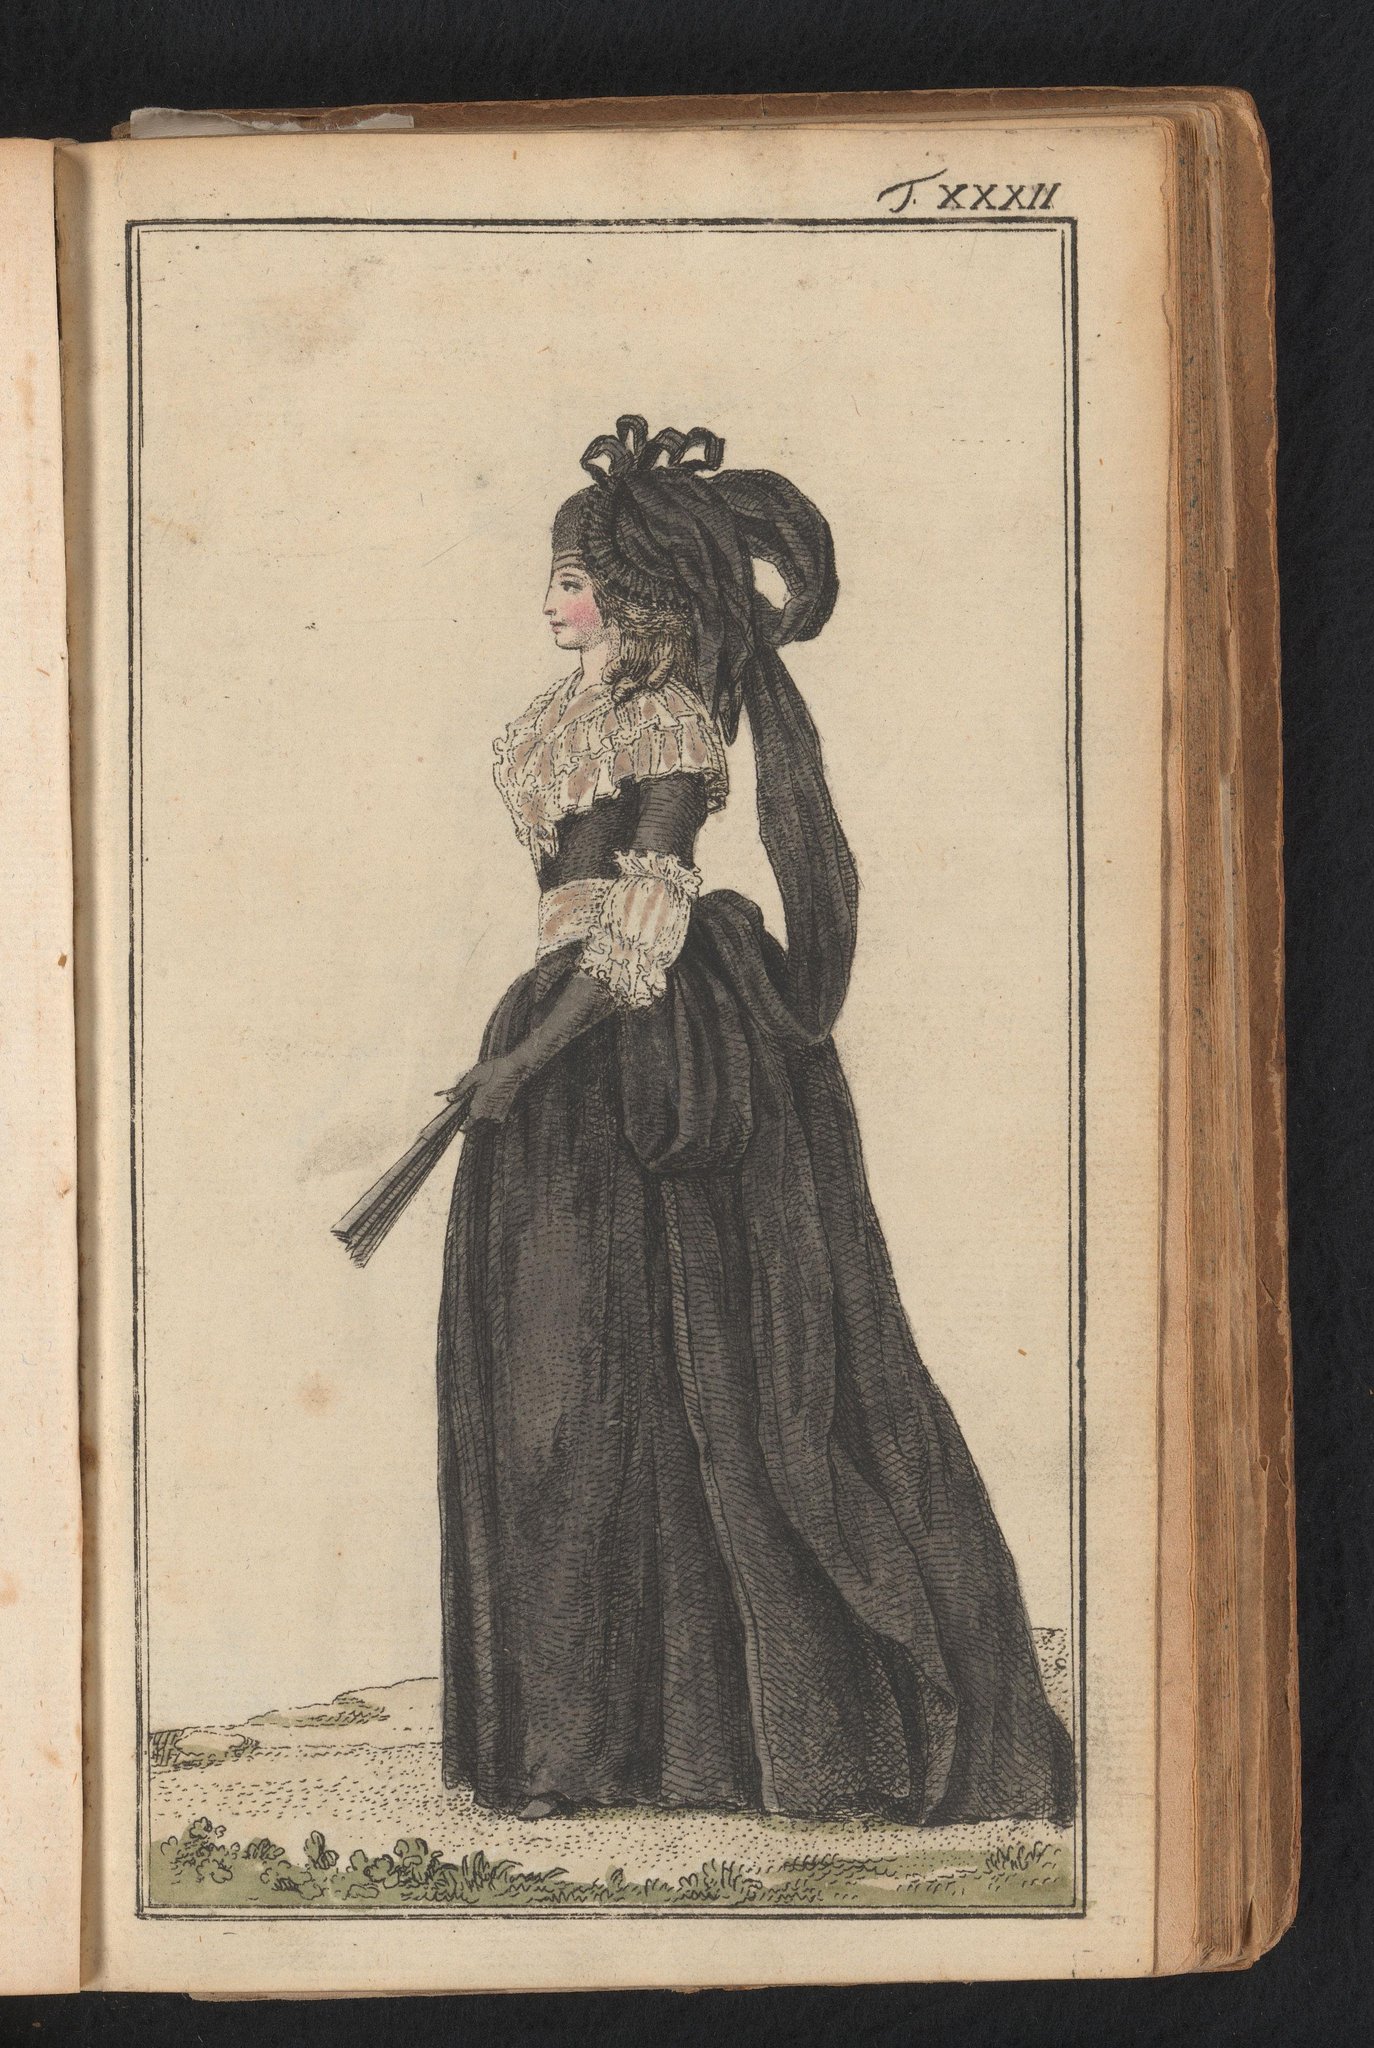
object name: fashion print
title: Journal des Luxus und der Moden 1786, Band I, T. 32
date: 1786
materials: paper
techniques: etching, hand coloring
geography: weimar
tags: head-gear: cap (+ women's clothes), fashion plates, dress, gown (+ women's clothes), mourning dress, fan (+ women's clothes)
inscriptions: number: ‘T.XXXII’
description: Berlijnse vrouw, gekleed in rouwkleding voor tweedegraads rouw (die zes maanden duurt). Zij draagt een zwarte Levite met mouwen en een fichu van witte crêpe. Om het middel een brede sjerp van witte crêpe. Op het hoofd een 'Fortune' van zwarte stof. Lange zwarte handschoenen. Een donkere dichtgevouwen waaier in de hand. Prent uit het modetijdschrift Journal des Luxus und der Moden, uitgegeven door Friedrich Justin Bertuch en Georg Melchior Kraus, Weimar, 1786-1826.